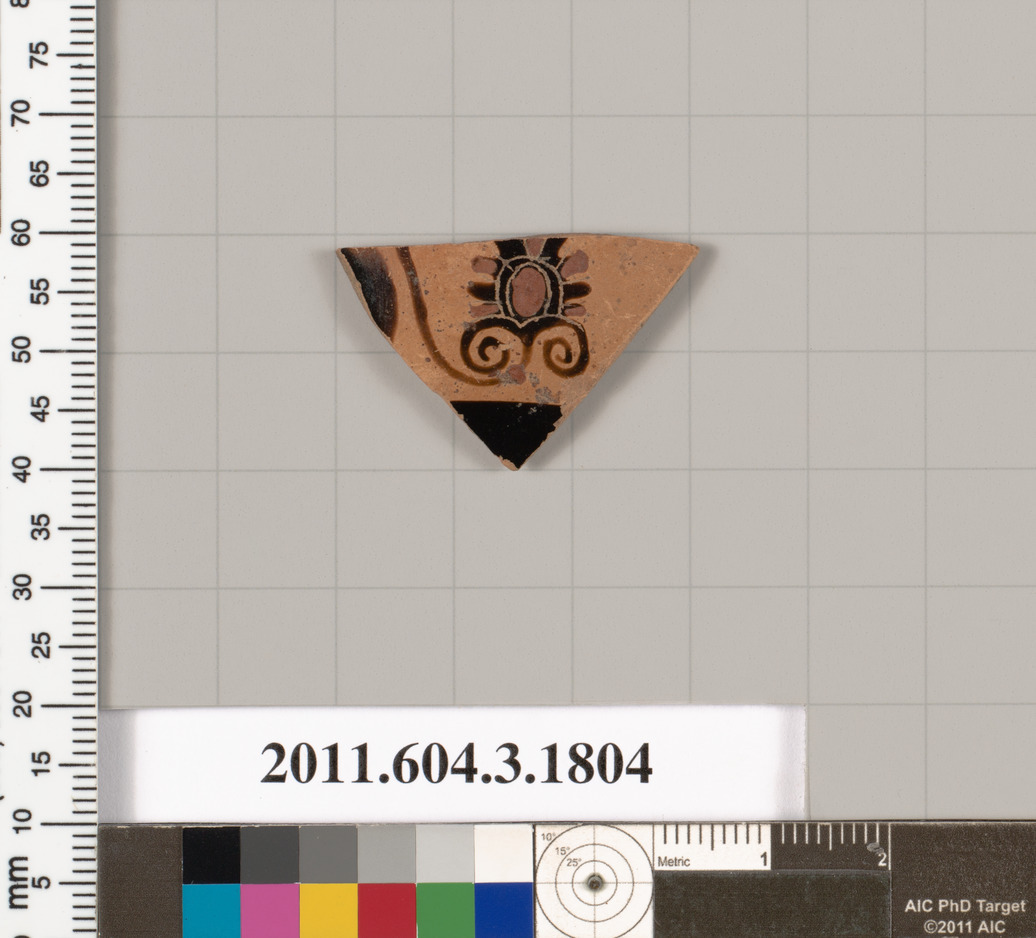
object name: kylix fragment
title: Terracotta fragment of a kylix: Lip cup (drinking cup)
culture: greek, attic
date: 567-535 BCE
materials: terracotta